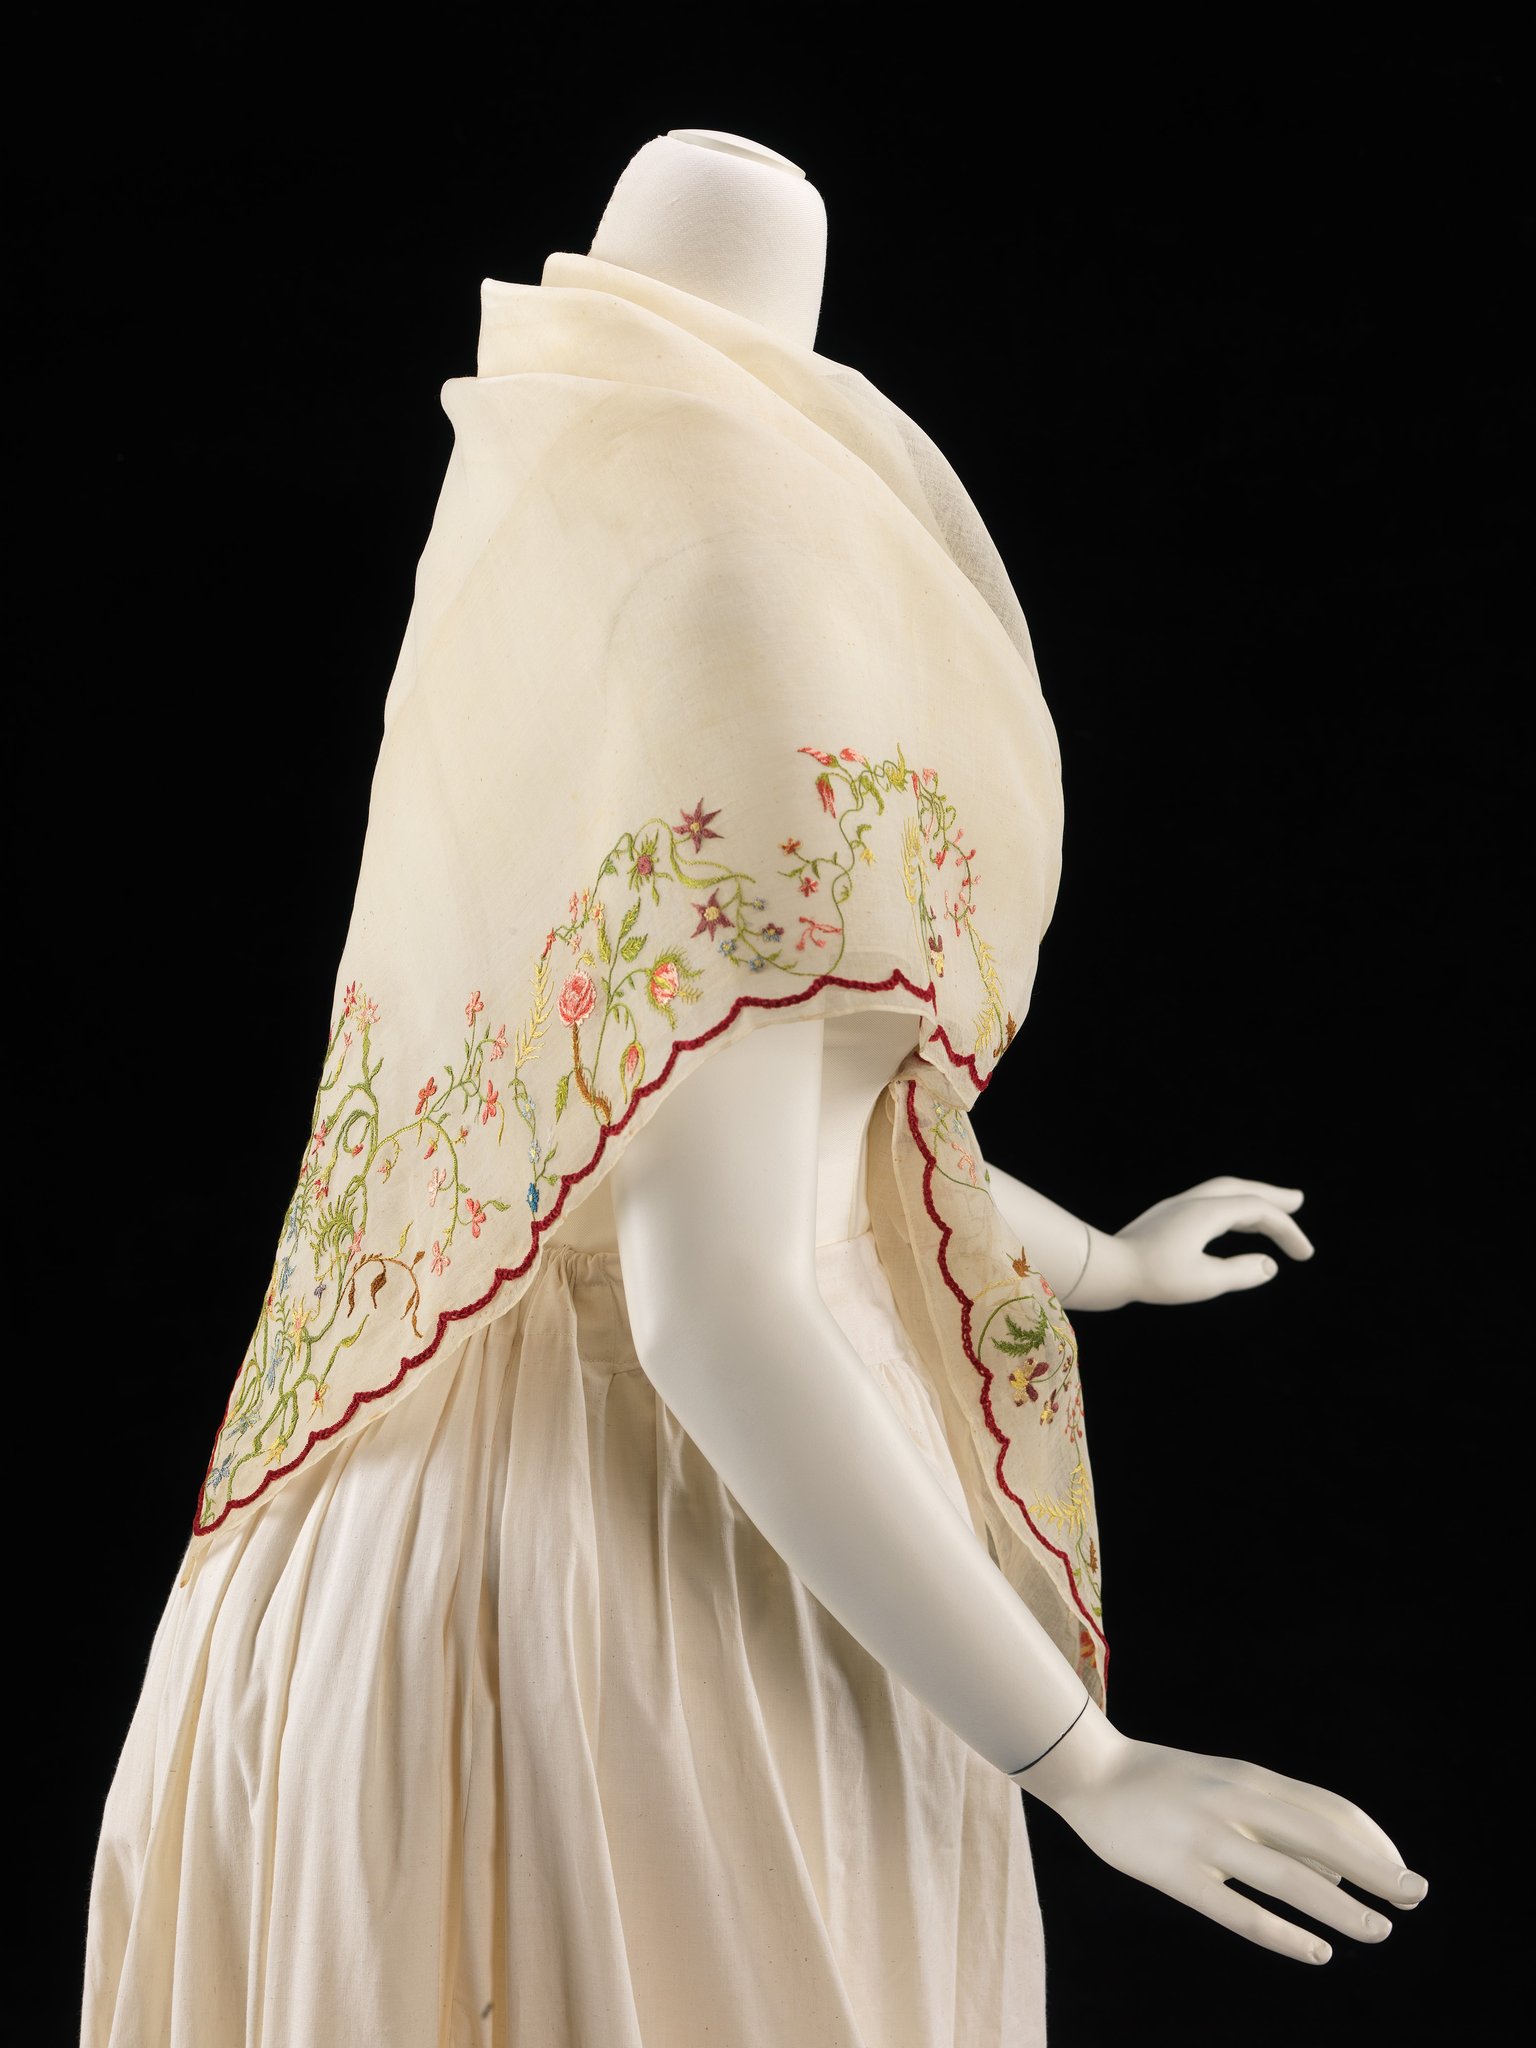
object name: fichu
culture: american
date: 1840-1860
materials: cotton, silk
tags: flowers